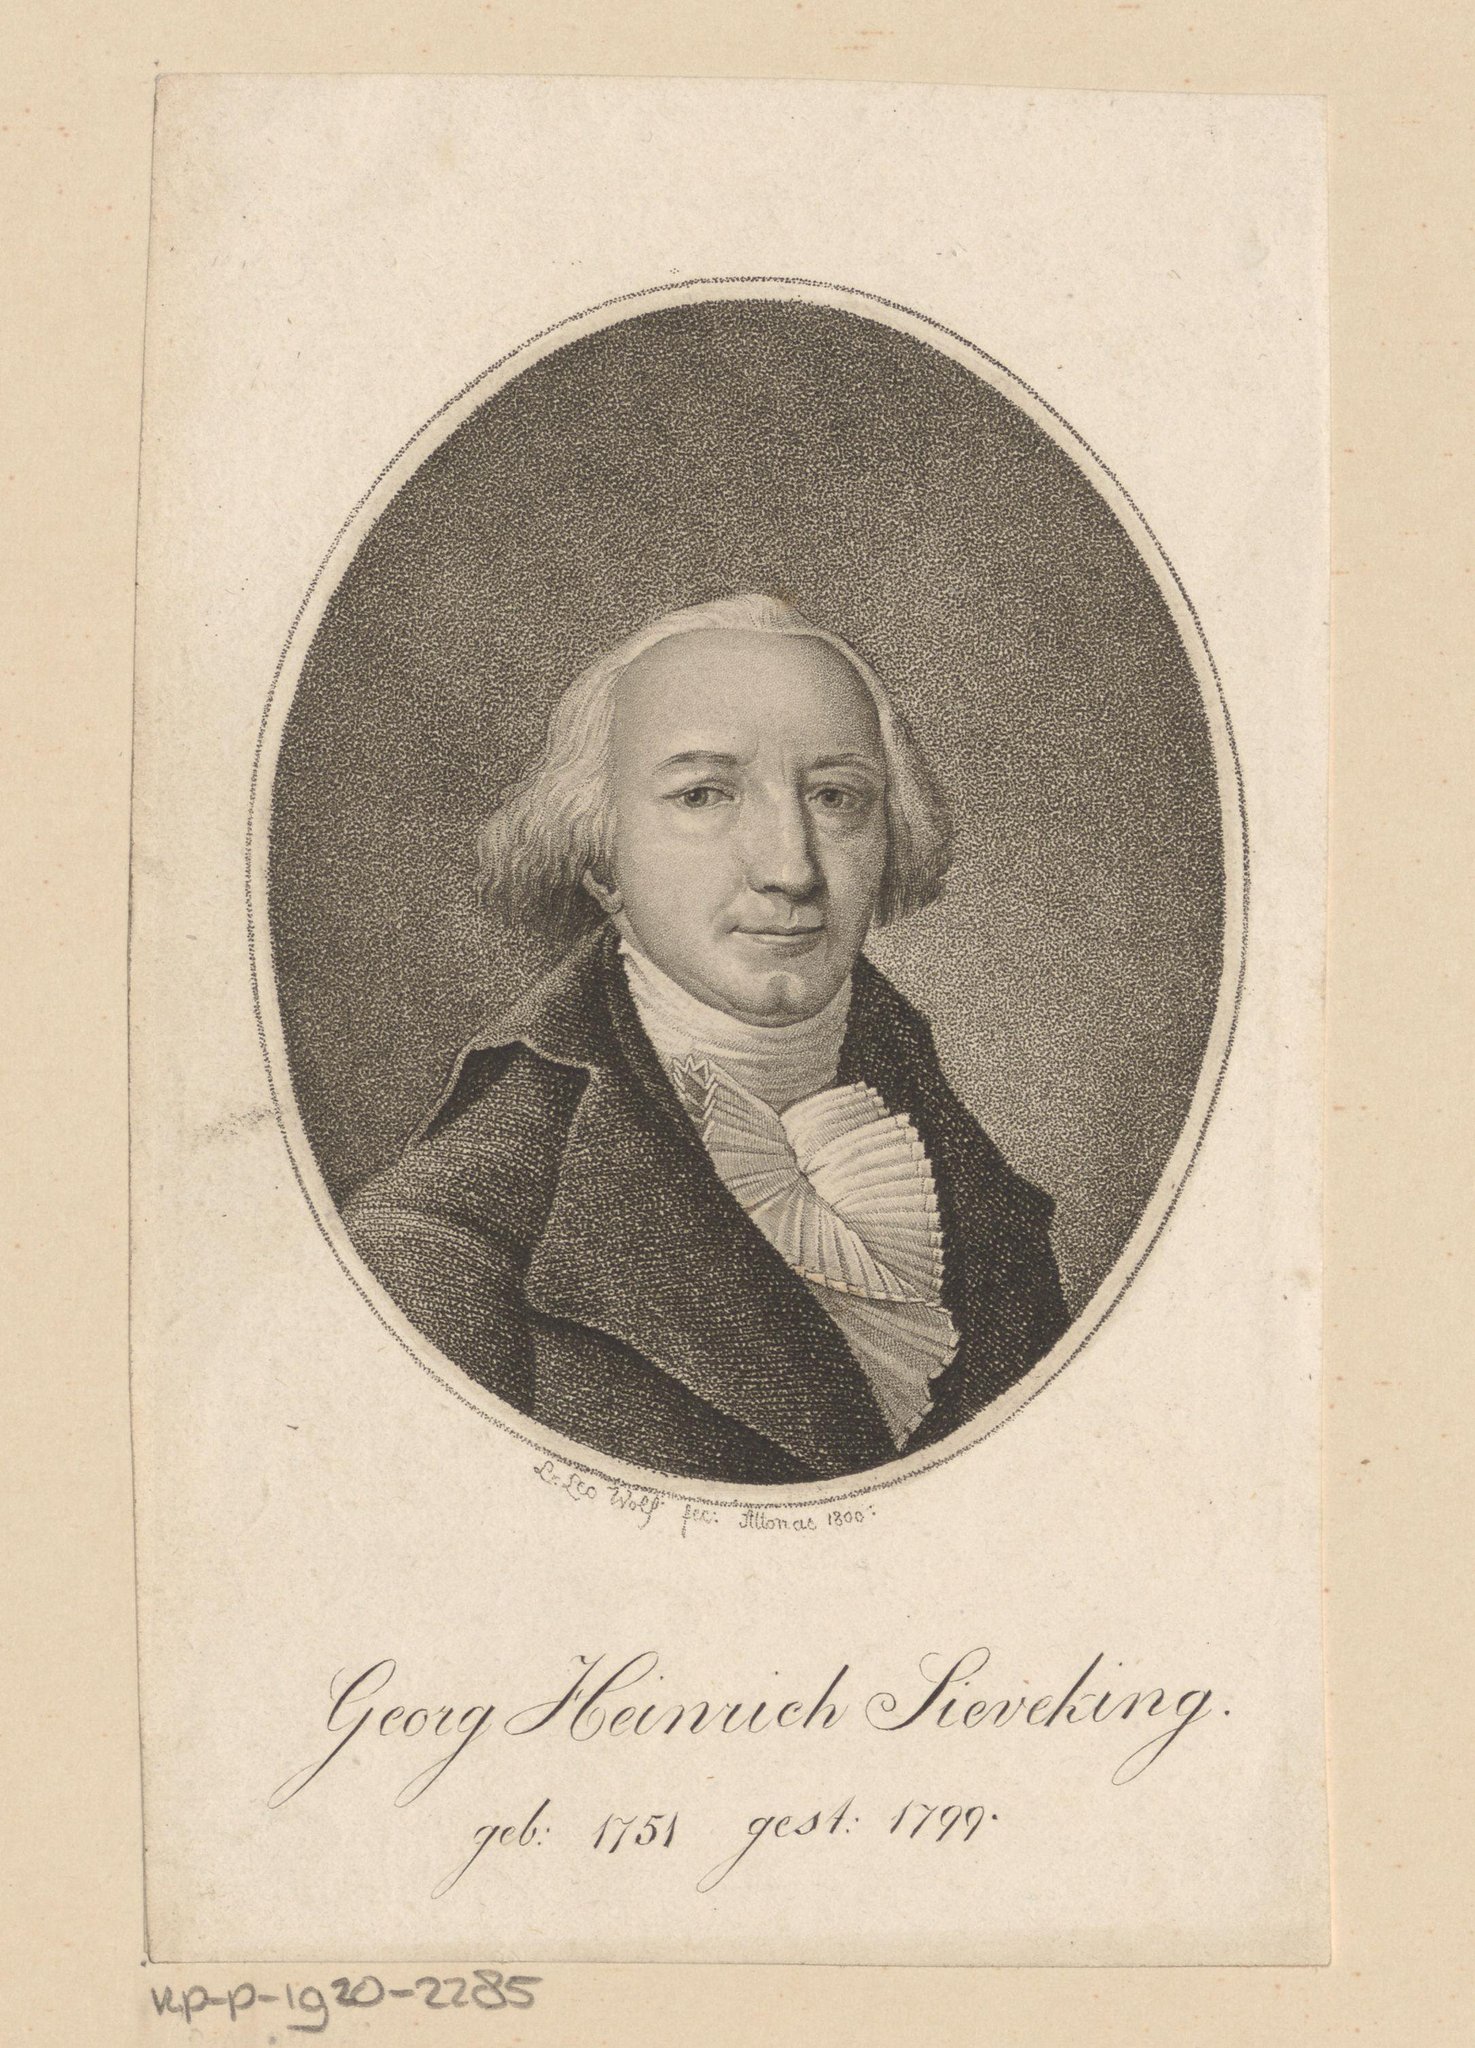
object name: print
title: Portret van Georg Heinrich Sieveking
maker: leo wolf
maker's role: draughtsman, print maker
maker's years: 1755-1840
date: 1800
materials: paper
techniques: etching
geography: altona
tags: historical persons, merchant, salesman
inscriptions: collector's mark: Lugt 2228